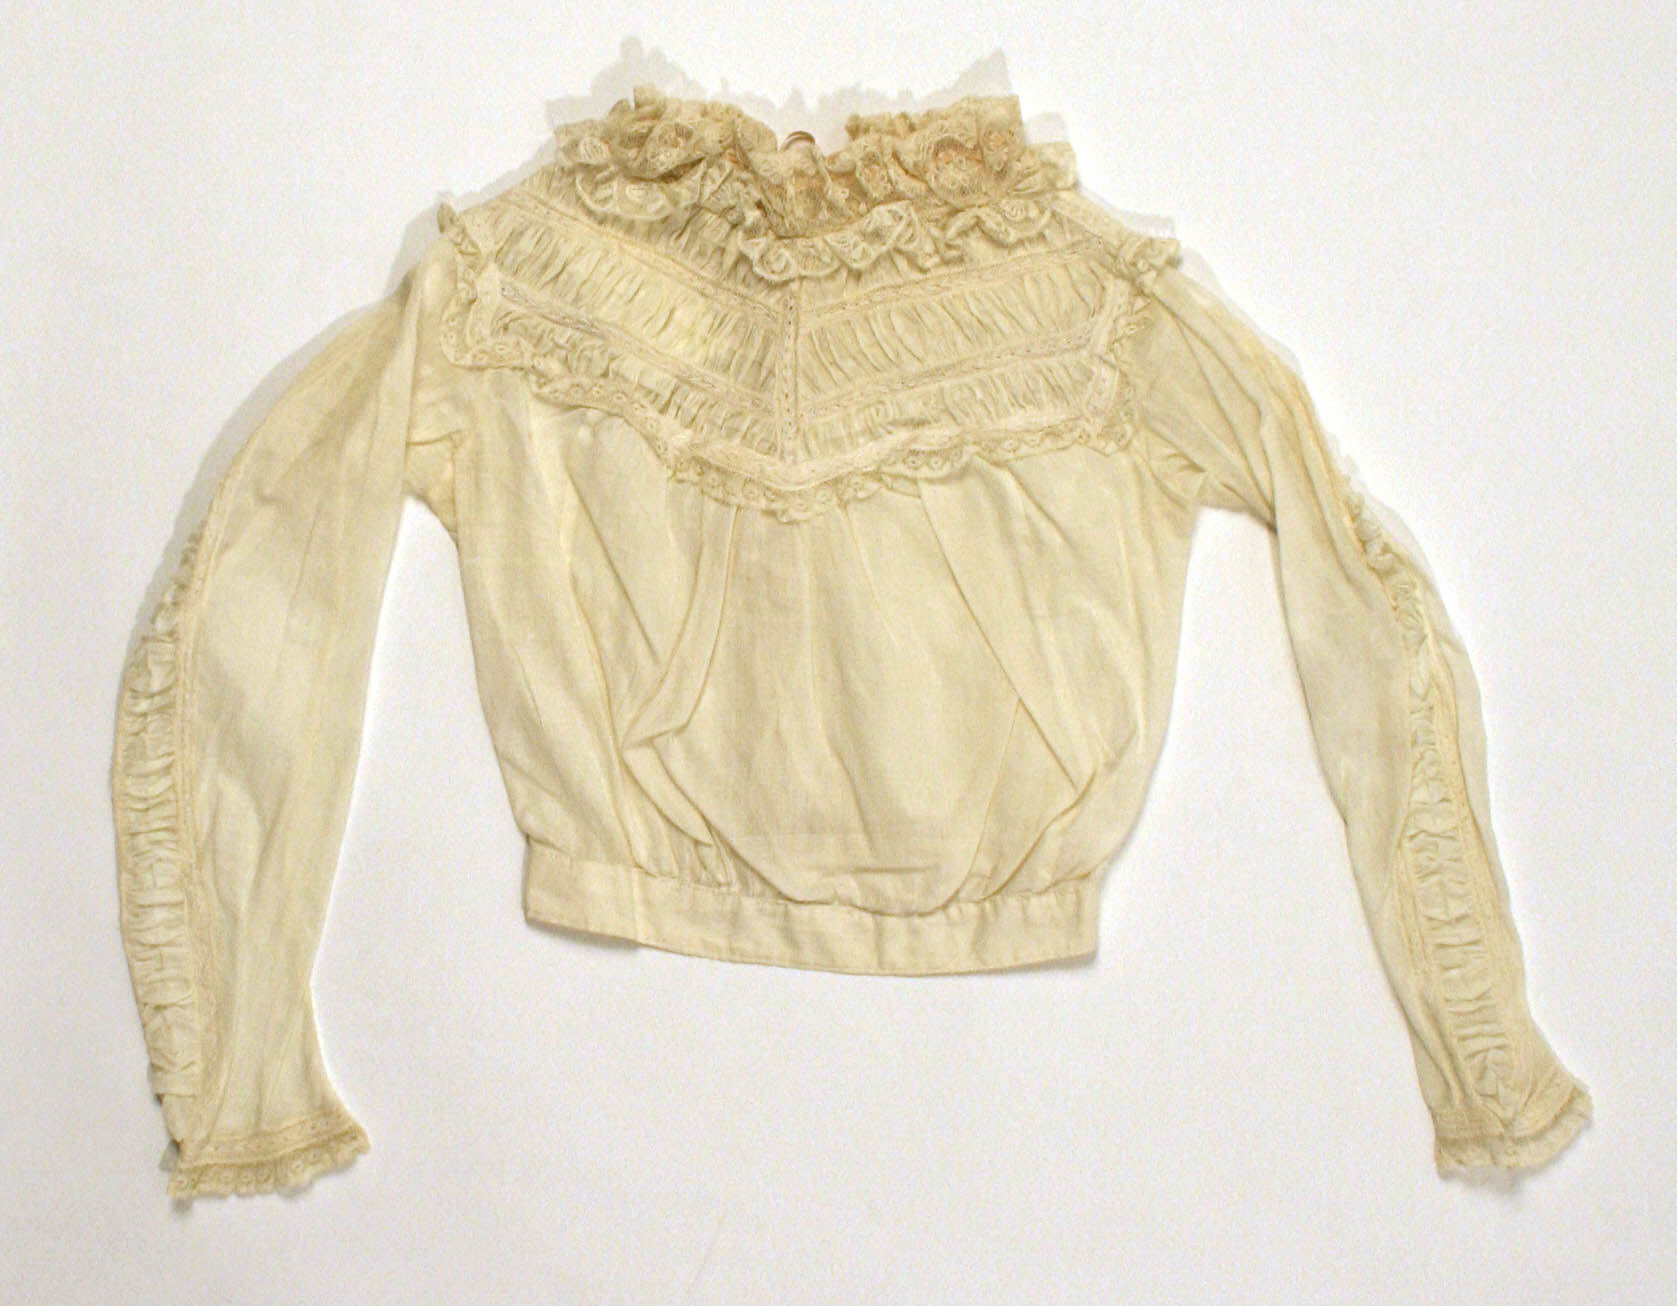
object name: dress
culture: american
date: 1860-1869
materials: cotton